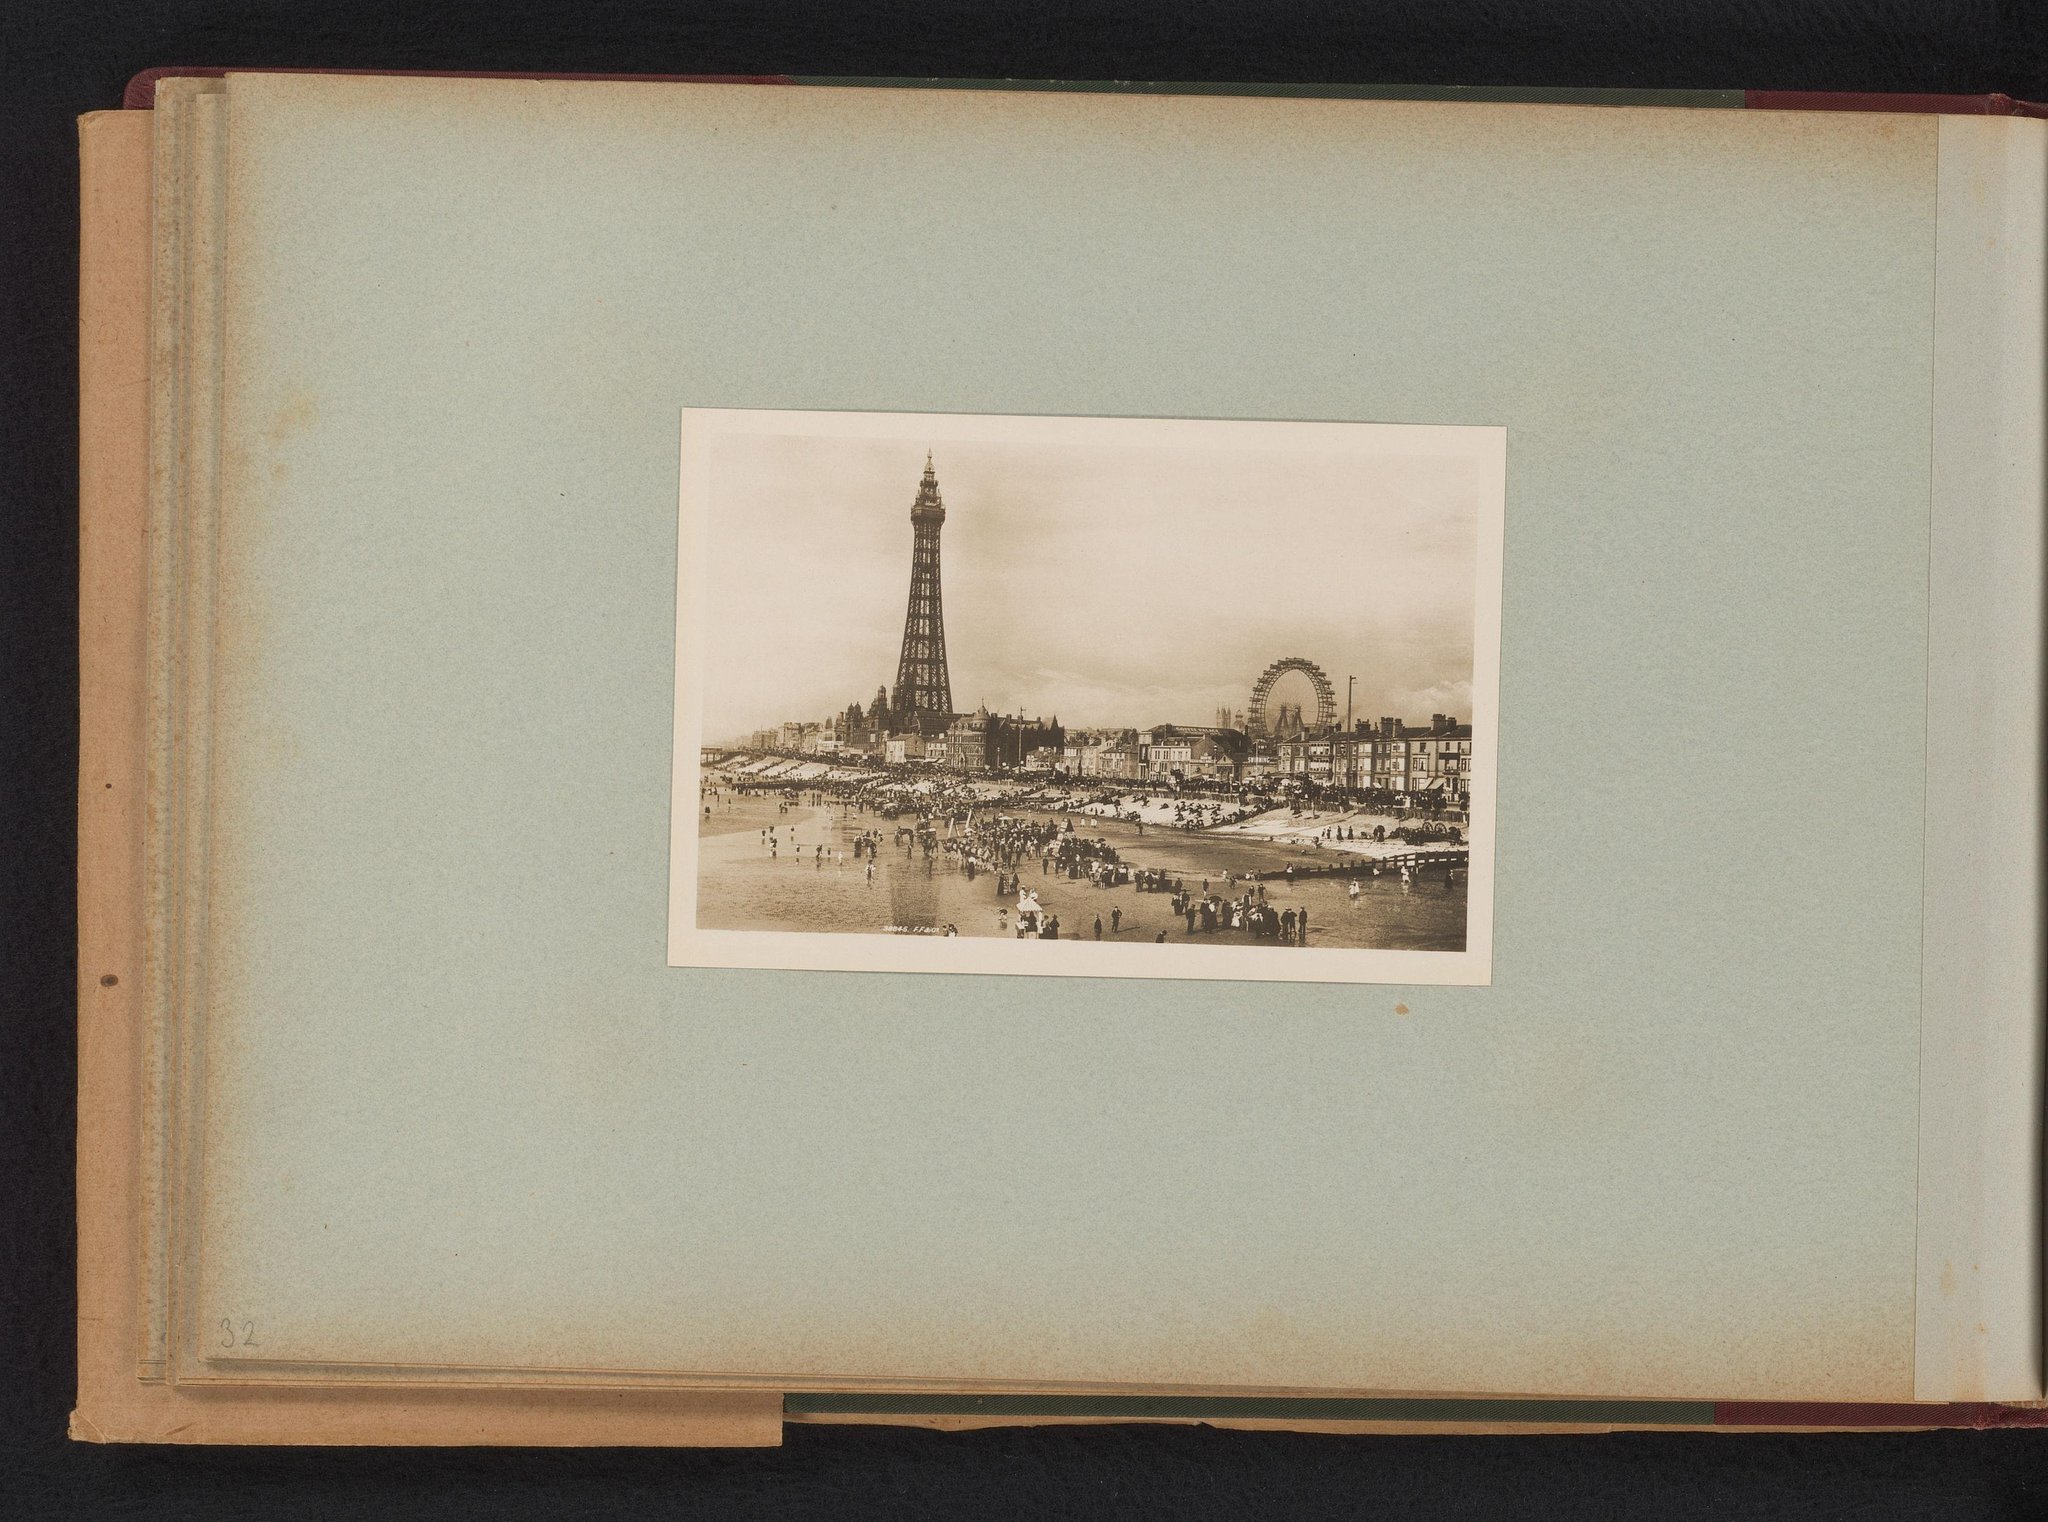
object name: photograph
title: Gezicht op het strand en de boulevard van Blackpool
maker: Anonymous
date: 1880-1900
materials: paper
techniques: gelatin silver print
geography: blackpool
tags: giant wheel, ferris wheel, landscape with tower or castle, avenue, boulevard, promenade, esplanade, beach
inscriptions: number: ‘38845’